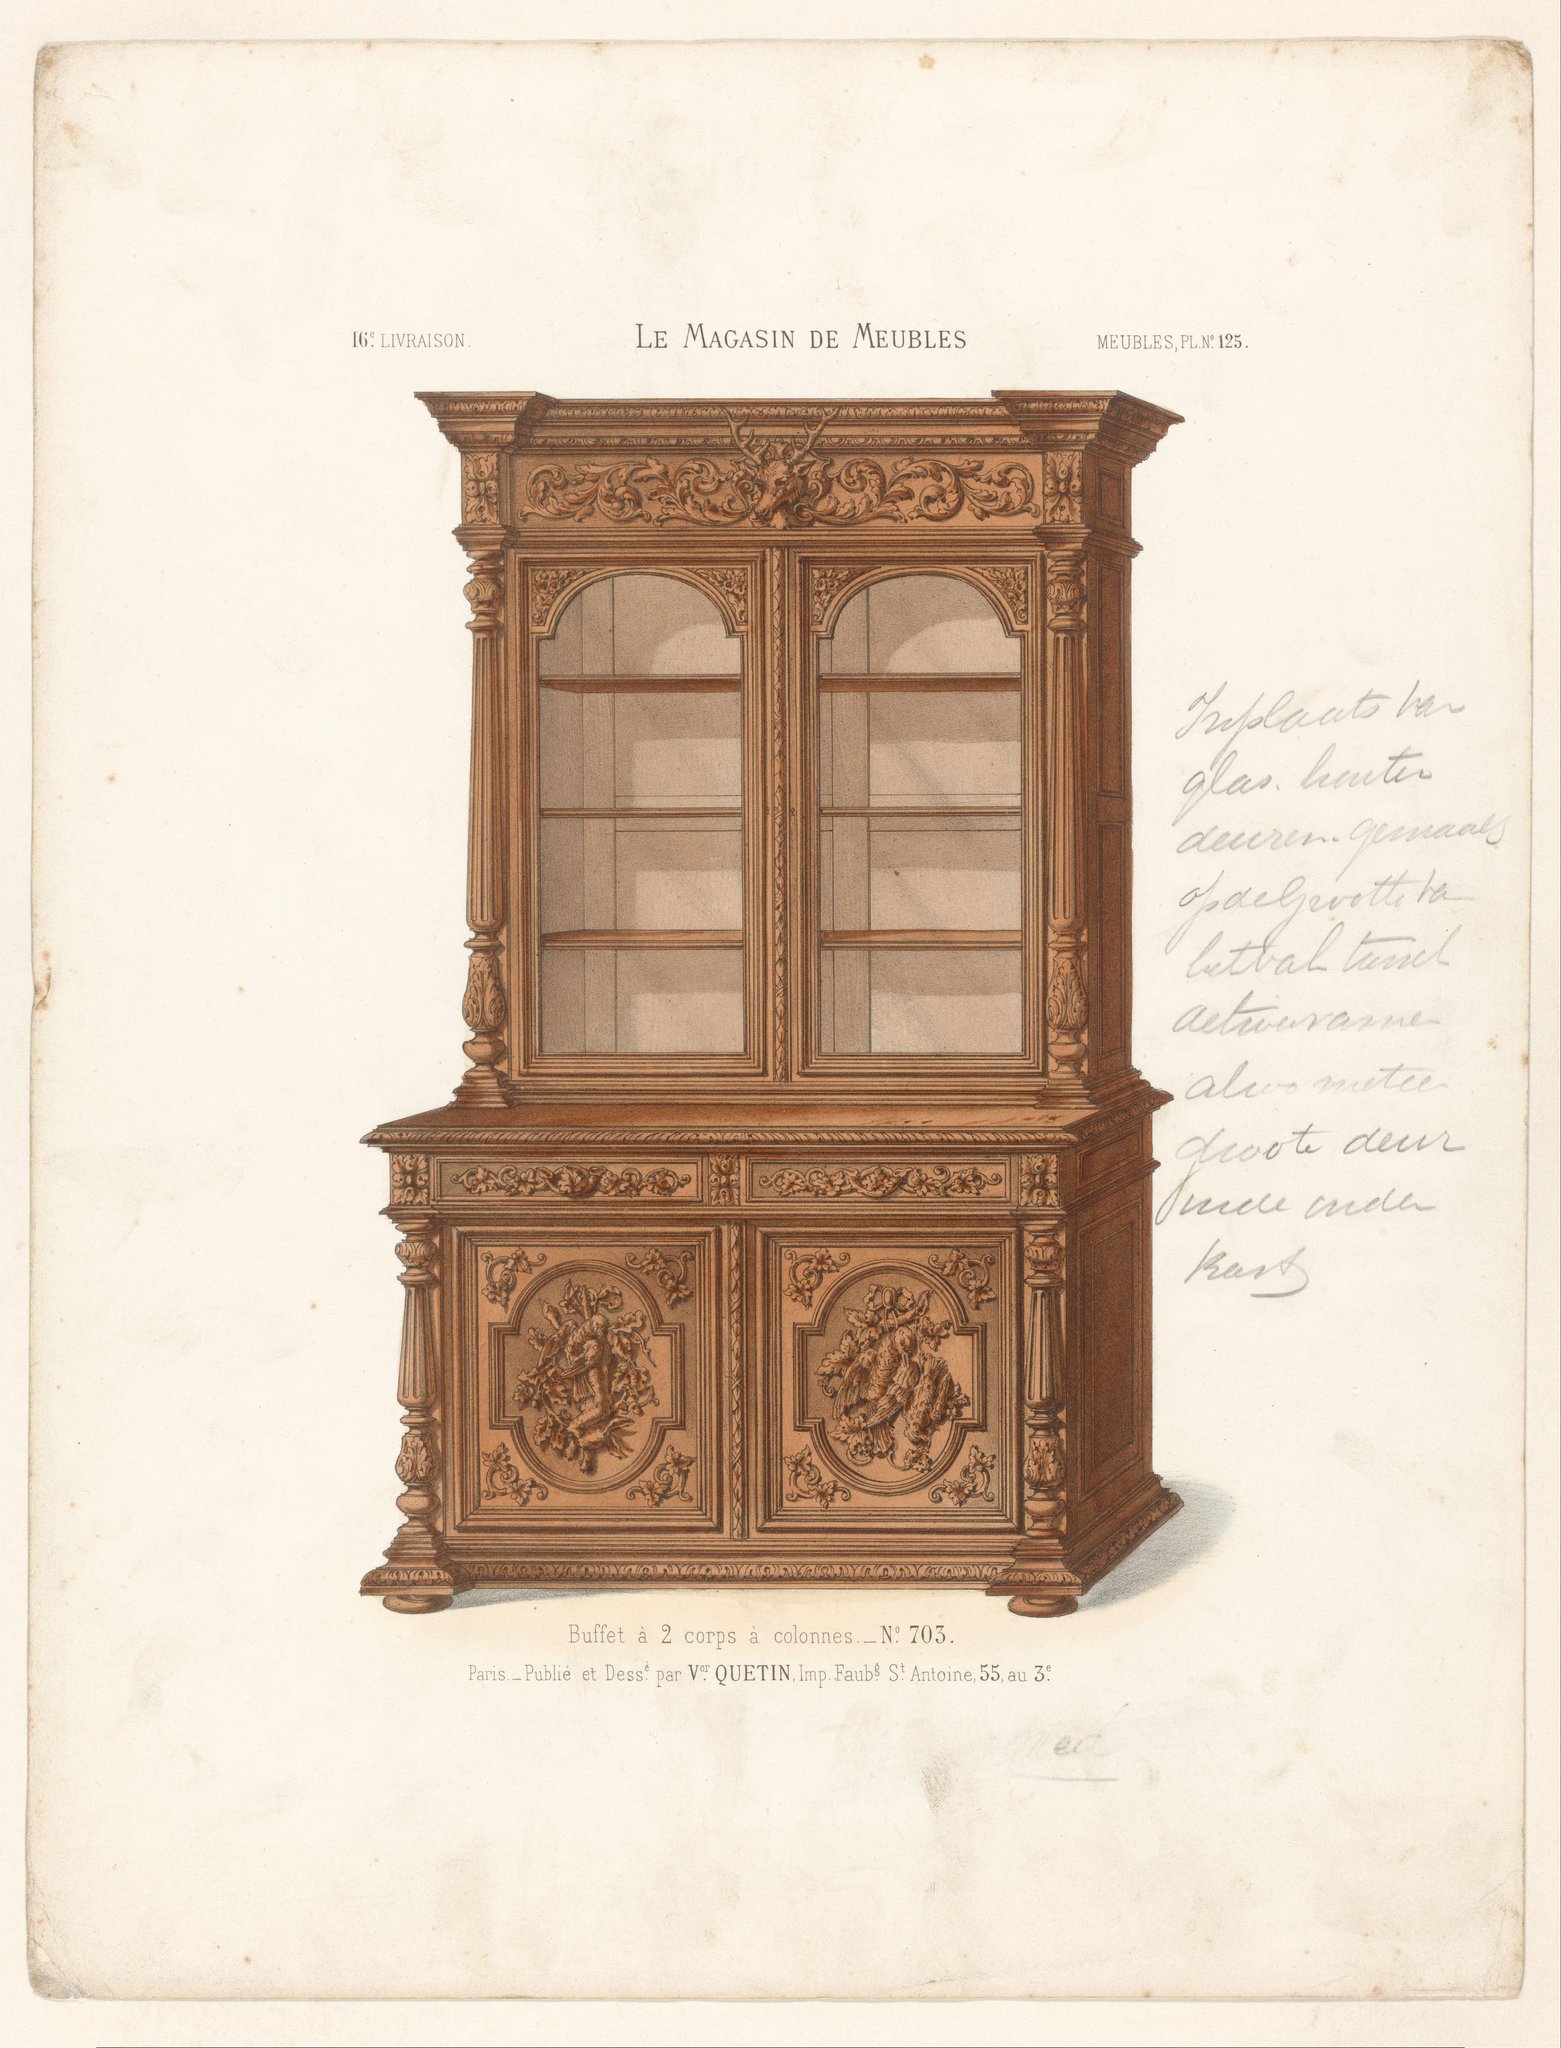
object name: print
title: Buffetkast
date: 1832-1877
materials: paper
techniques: hand coloring, lithograph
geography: paris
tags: furniture for storage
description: Een buffetkast. Prent uit 16e Livraison.